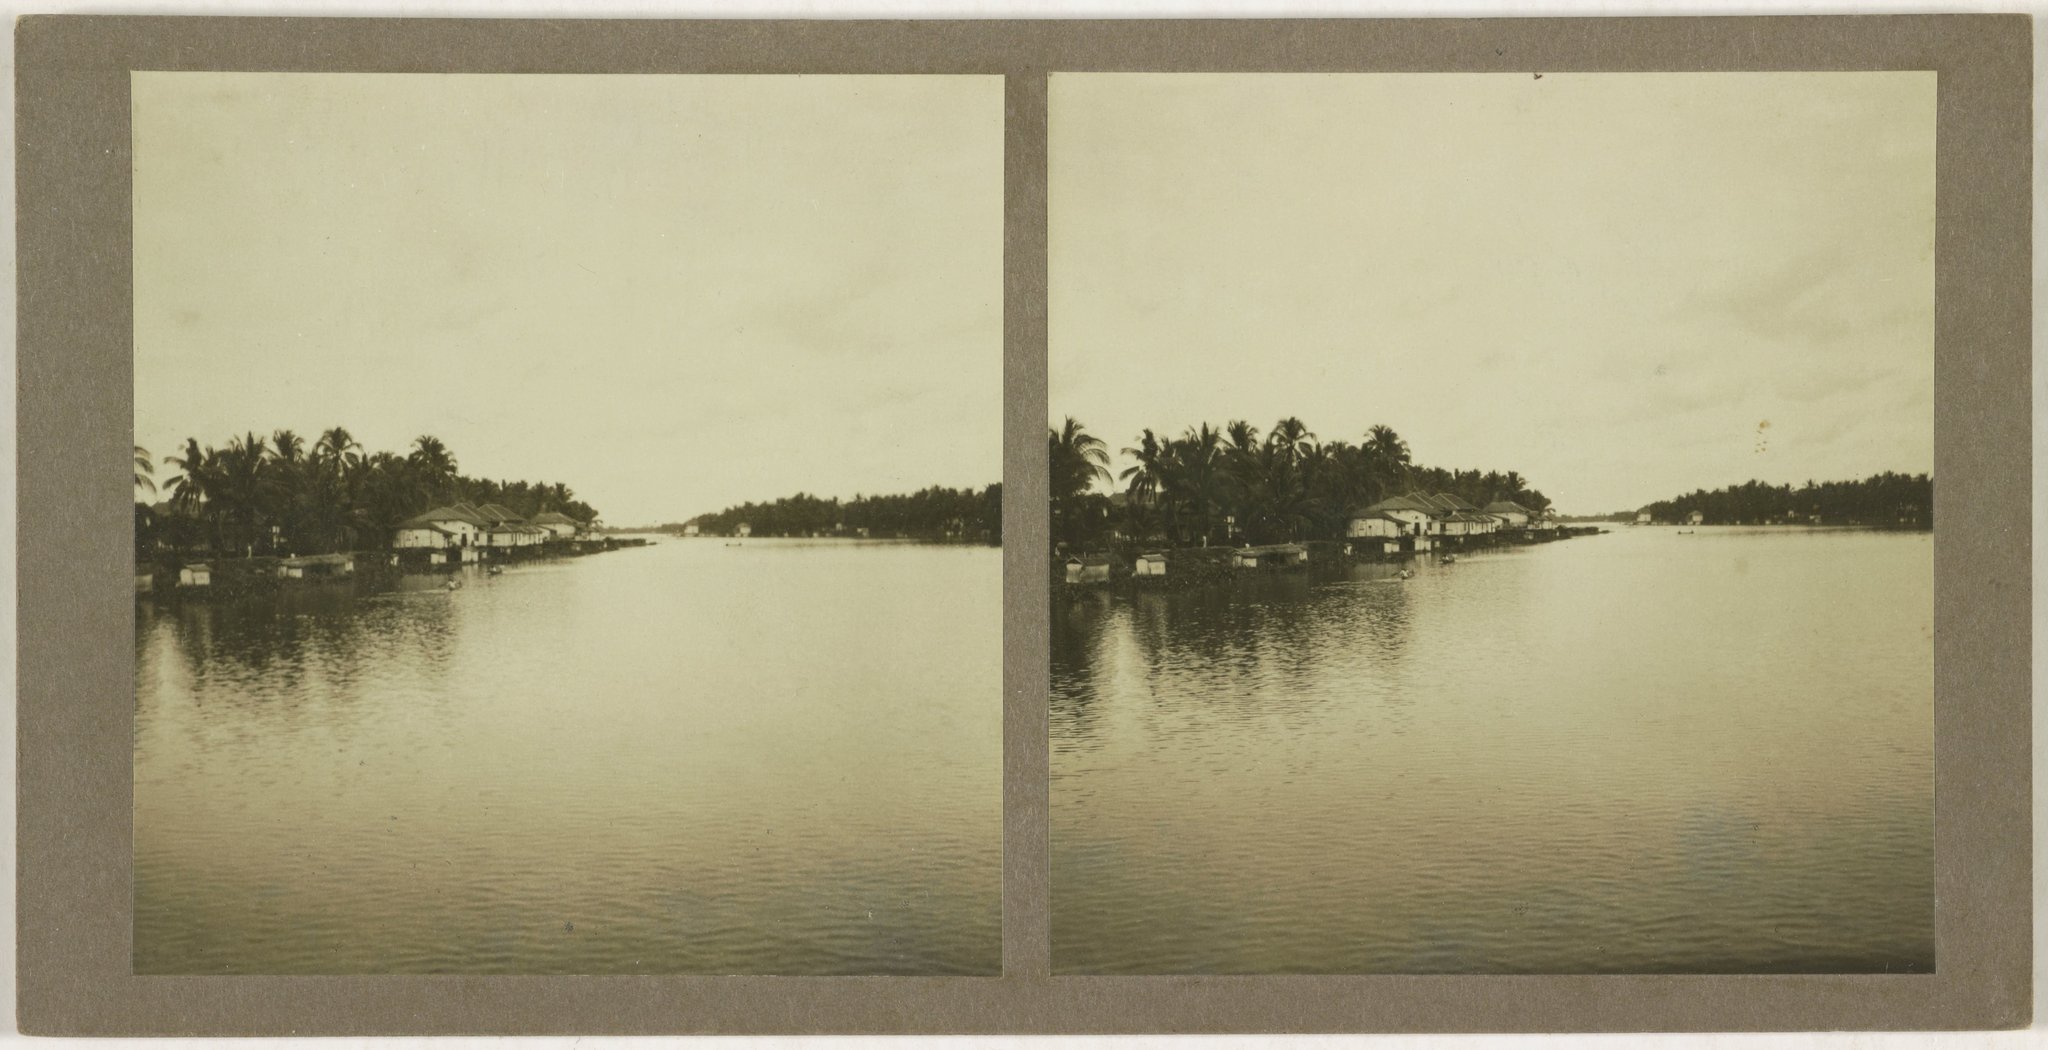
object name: stereograph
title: Gezicht op de Sungai Negara rivier, Borneo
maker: Anonymous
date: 1900-1940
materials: paper, cardboard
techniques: gelatin silver print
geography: sungai negara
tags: river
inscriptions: inscription: ‘Negara rivier bij/ Negara/ Z. en O. oW. Borneo.’